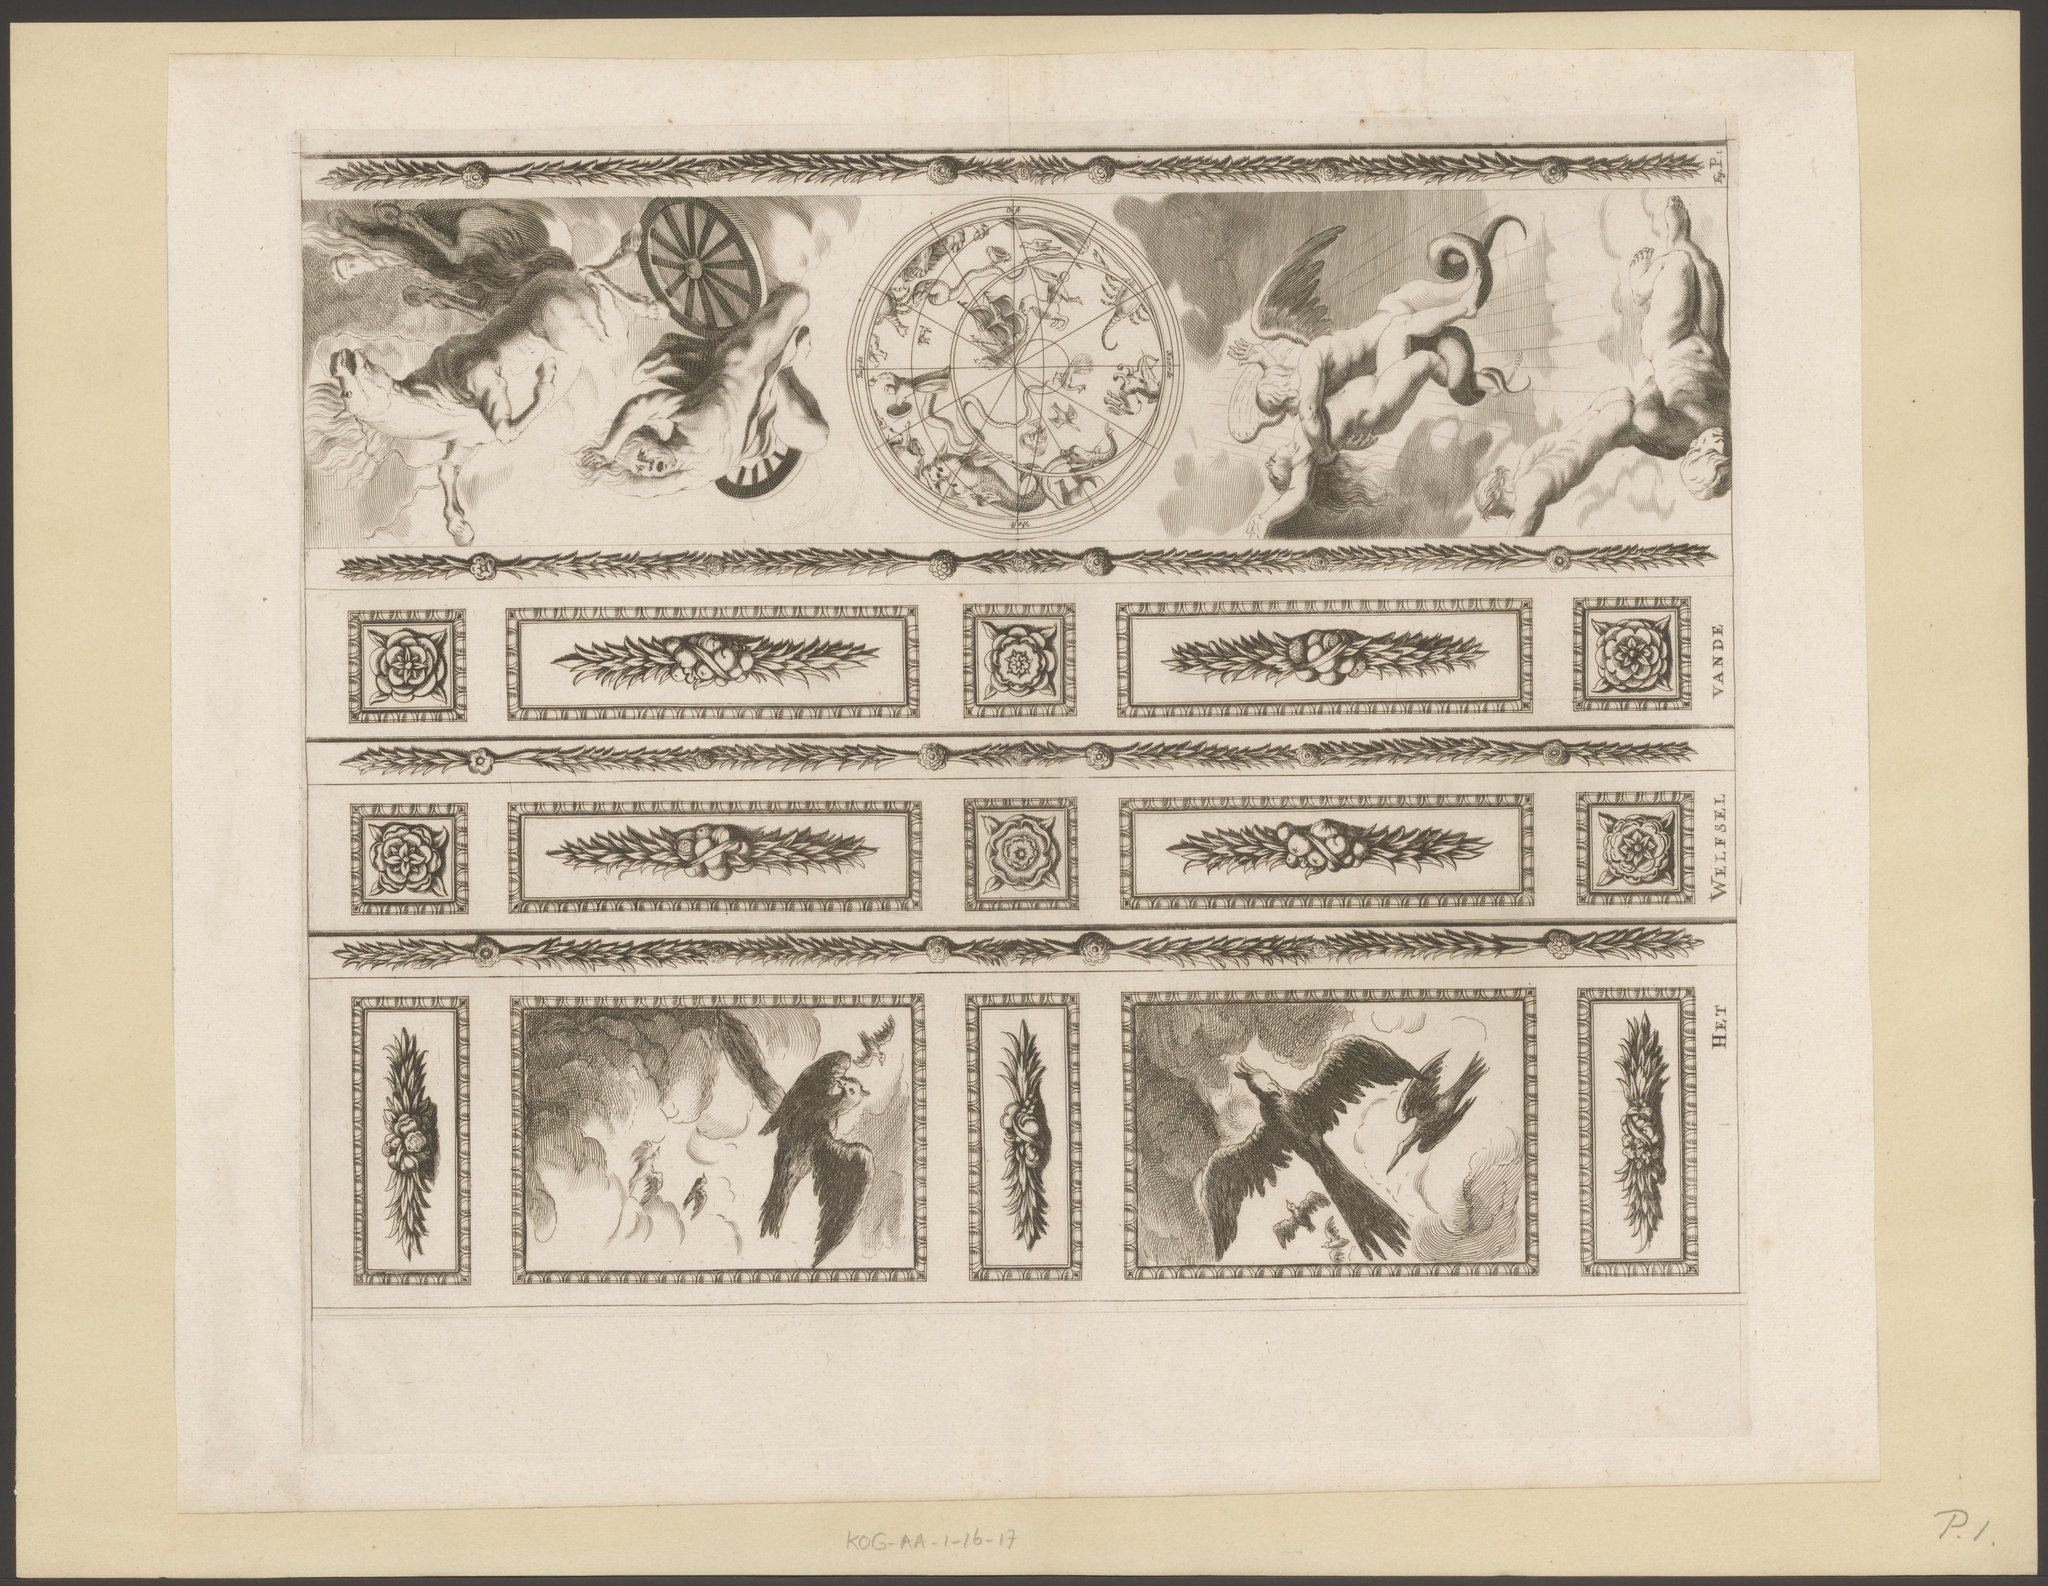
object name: print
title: Het Welfsel vande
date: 1661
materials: paper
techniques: engraving, etching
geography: amsterdam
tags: interior ~ architectural design or model, townhall, (decorated) ceiling, plan ~ architecture, fall of phaethon; he is struck by a thunderbolt of jupiter, star-chart, star map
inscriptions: collector's mark: ‘16,17’ Lugt 1641b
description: Onderwerpsrubriek binnen de Atlas Amsterdam: Stadhuis op de Dam. Rechtsonder: Fig. P. 1.